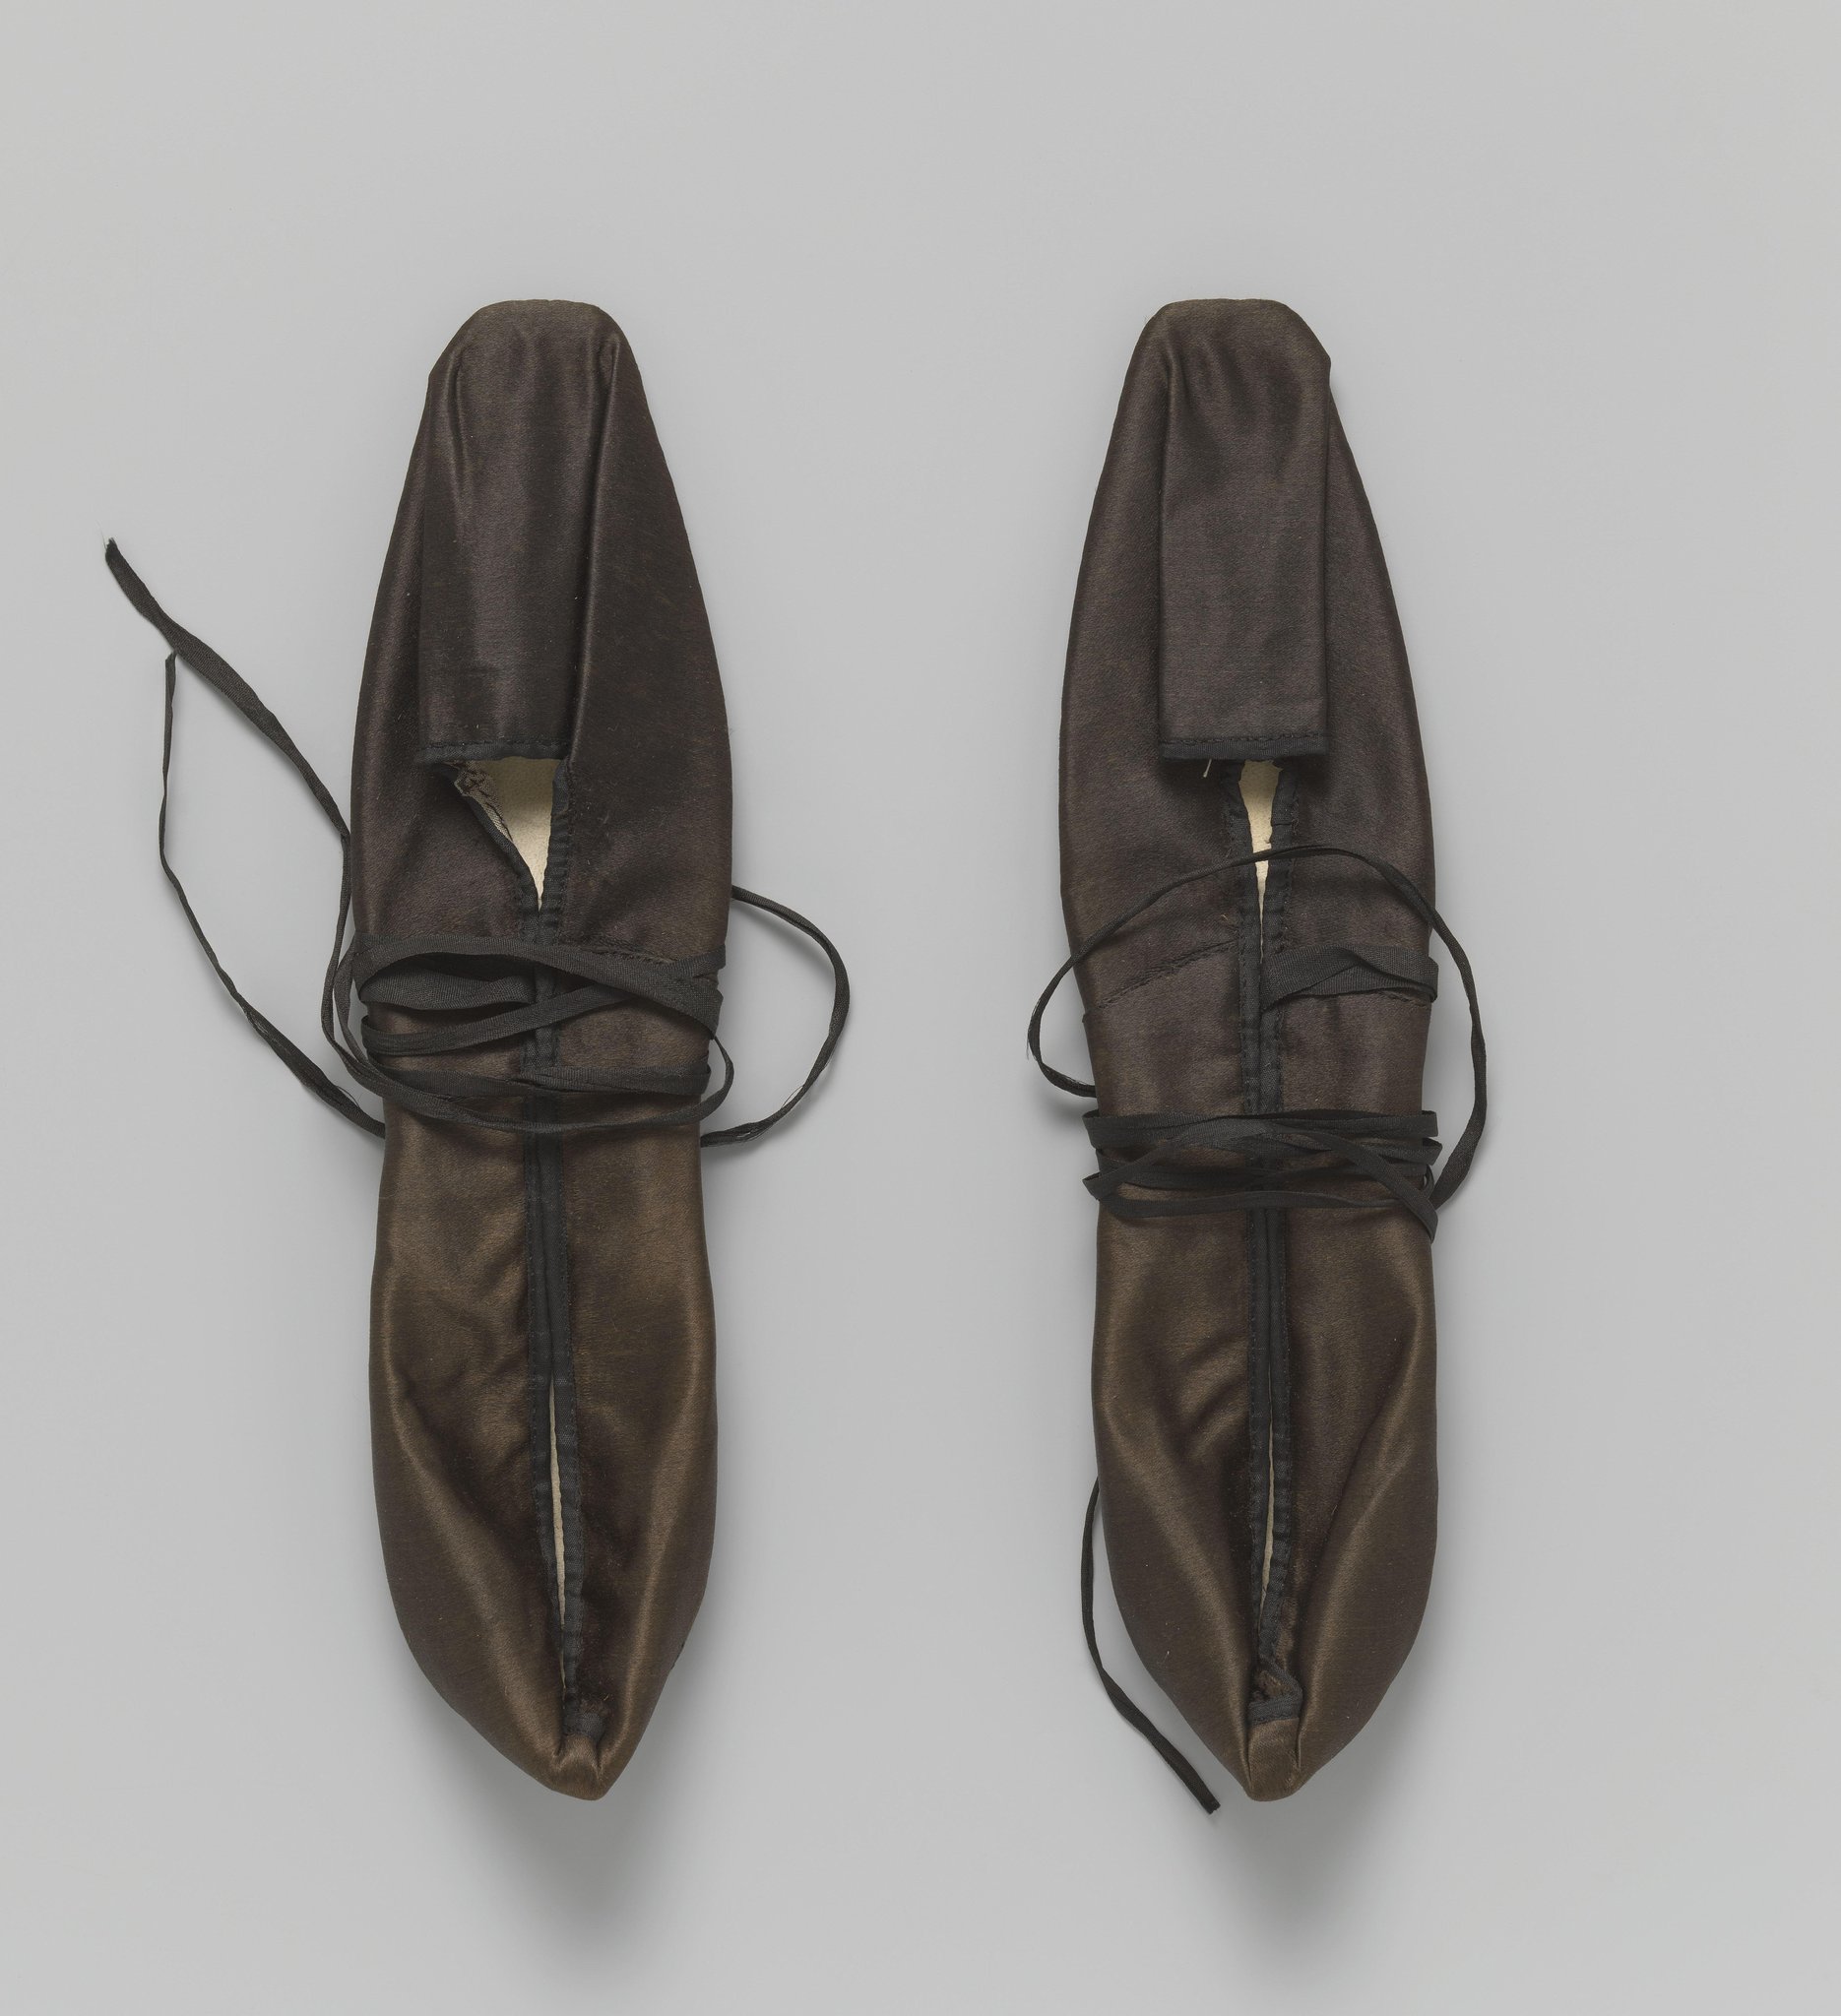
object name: shoe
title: Platte schoen van zwarte zijde met lint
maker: Anonymous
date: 1850-1930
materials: leather, silk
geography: europe